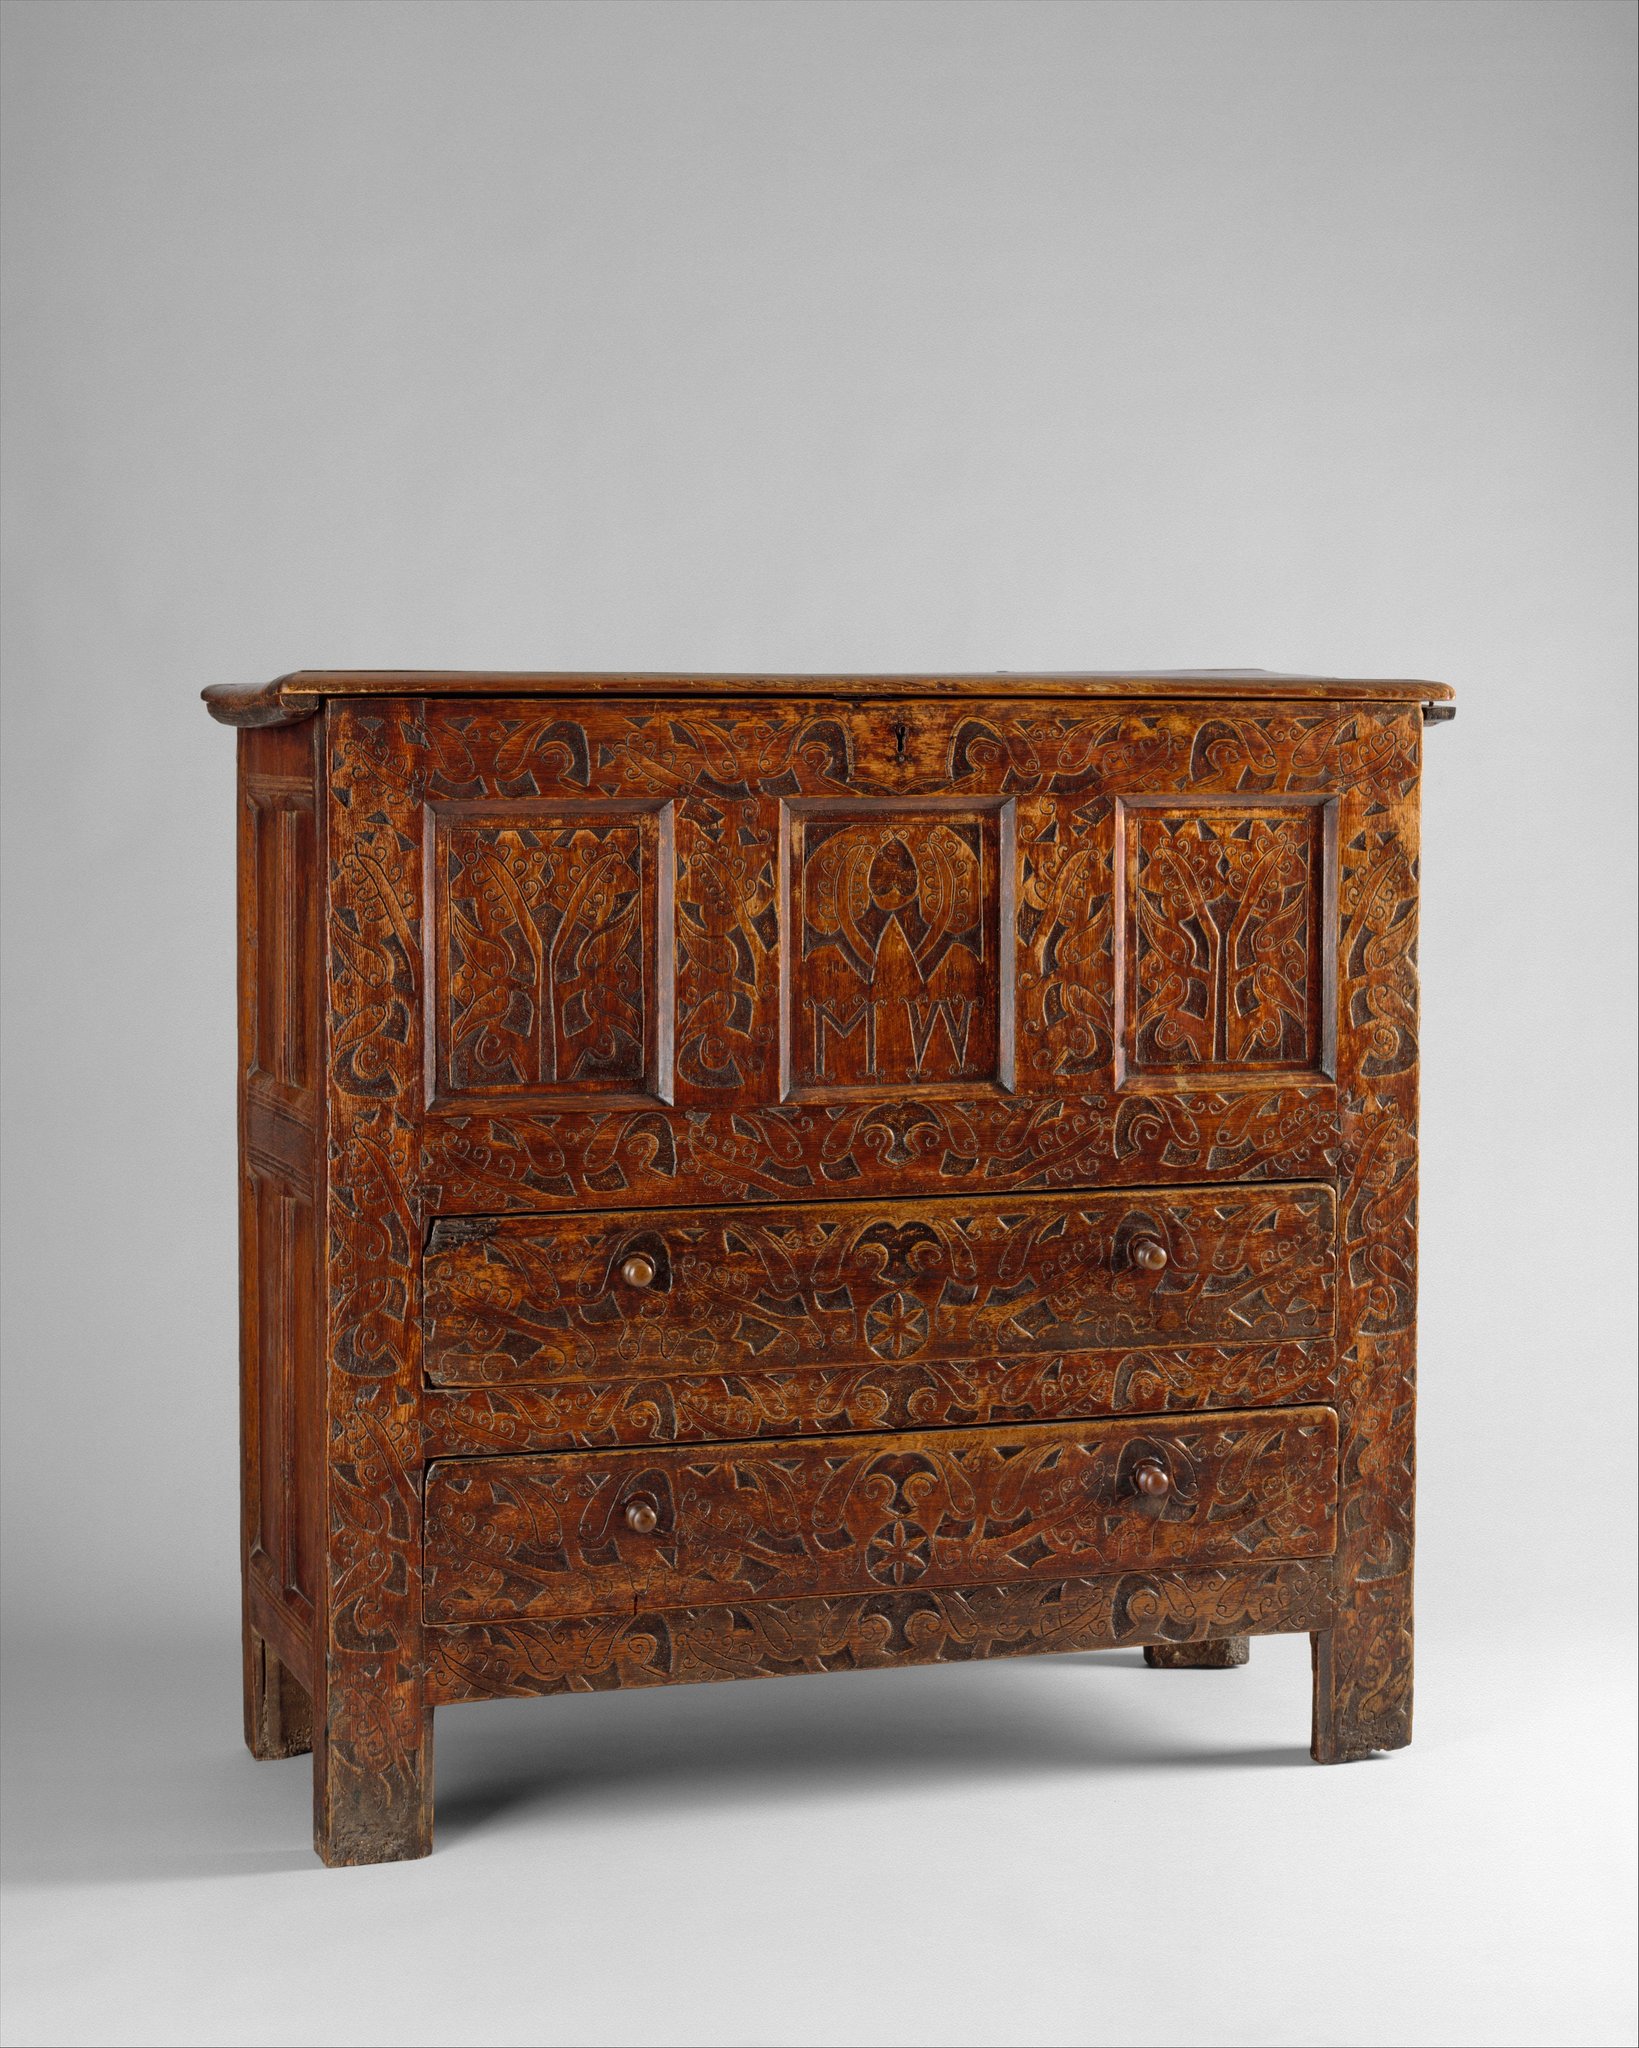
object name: chest of drawer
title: Chest-with-drawers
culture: american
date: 1690-1710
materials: wood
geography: united states